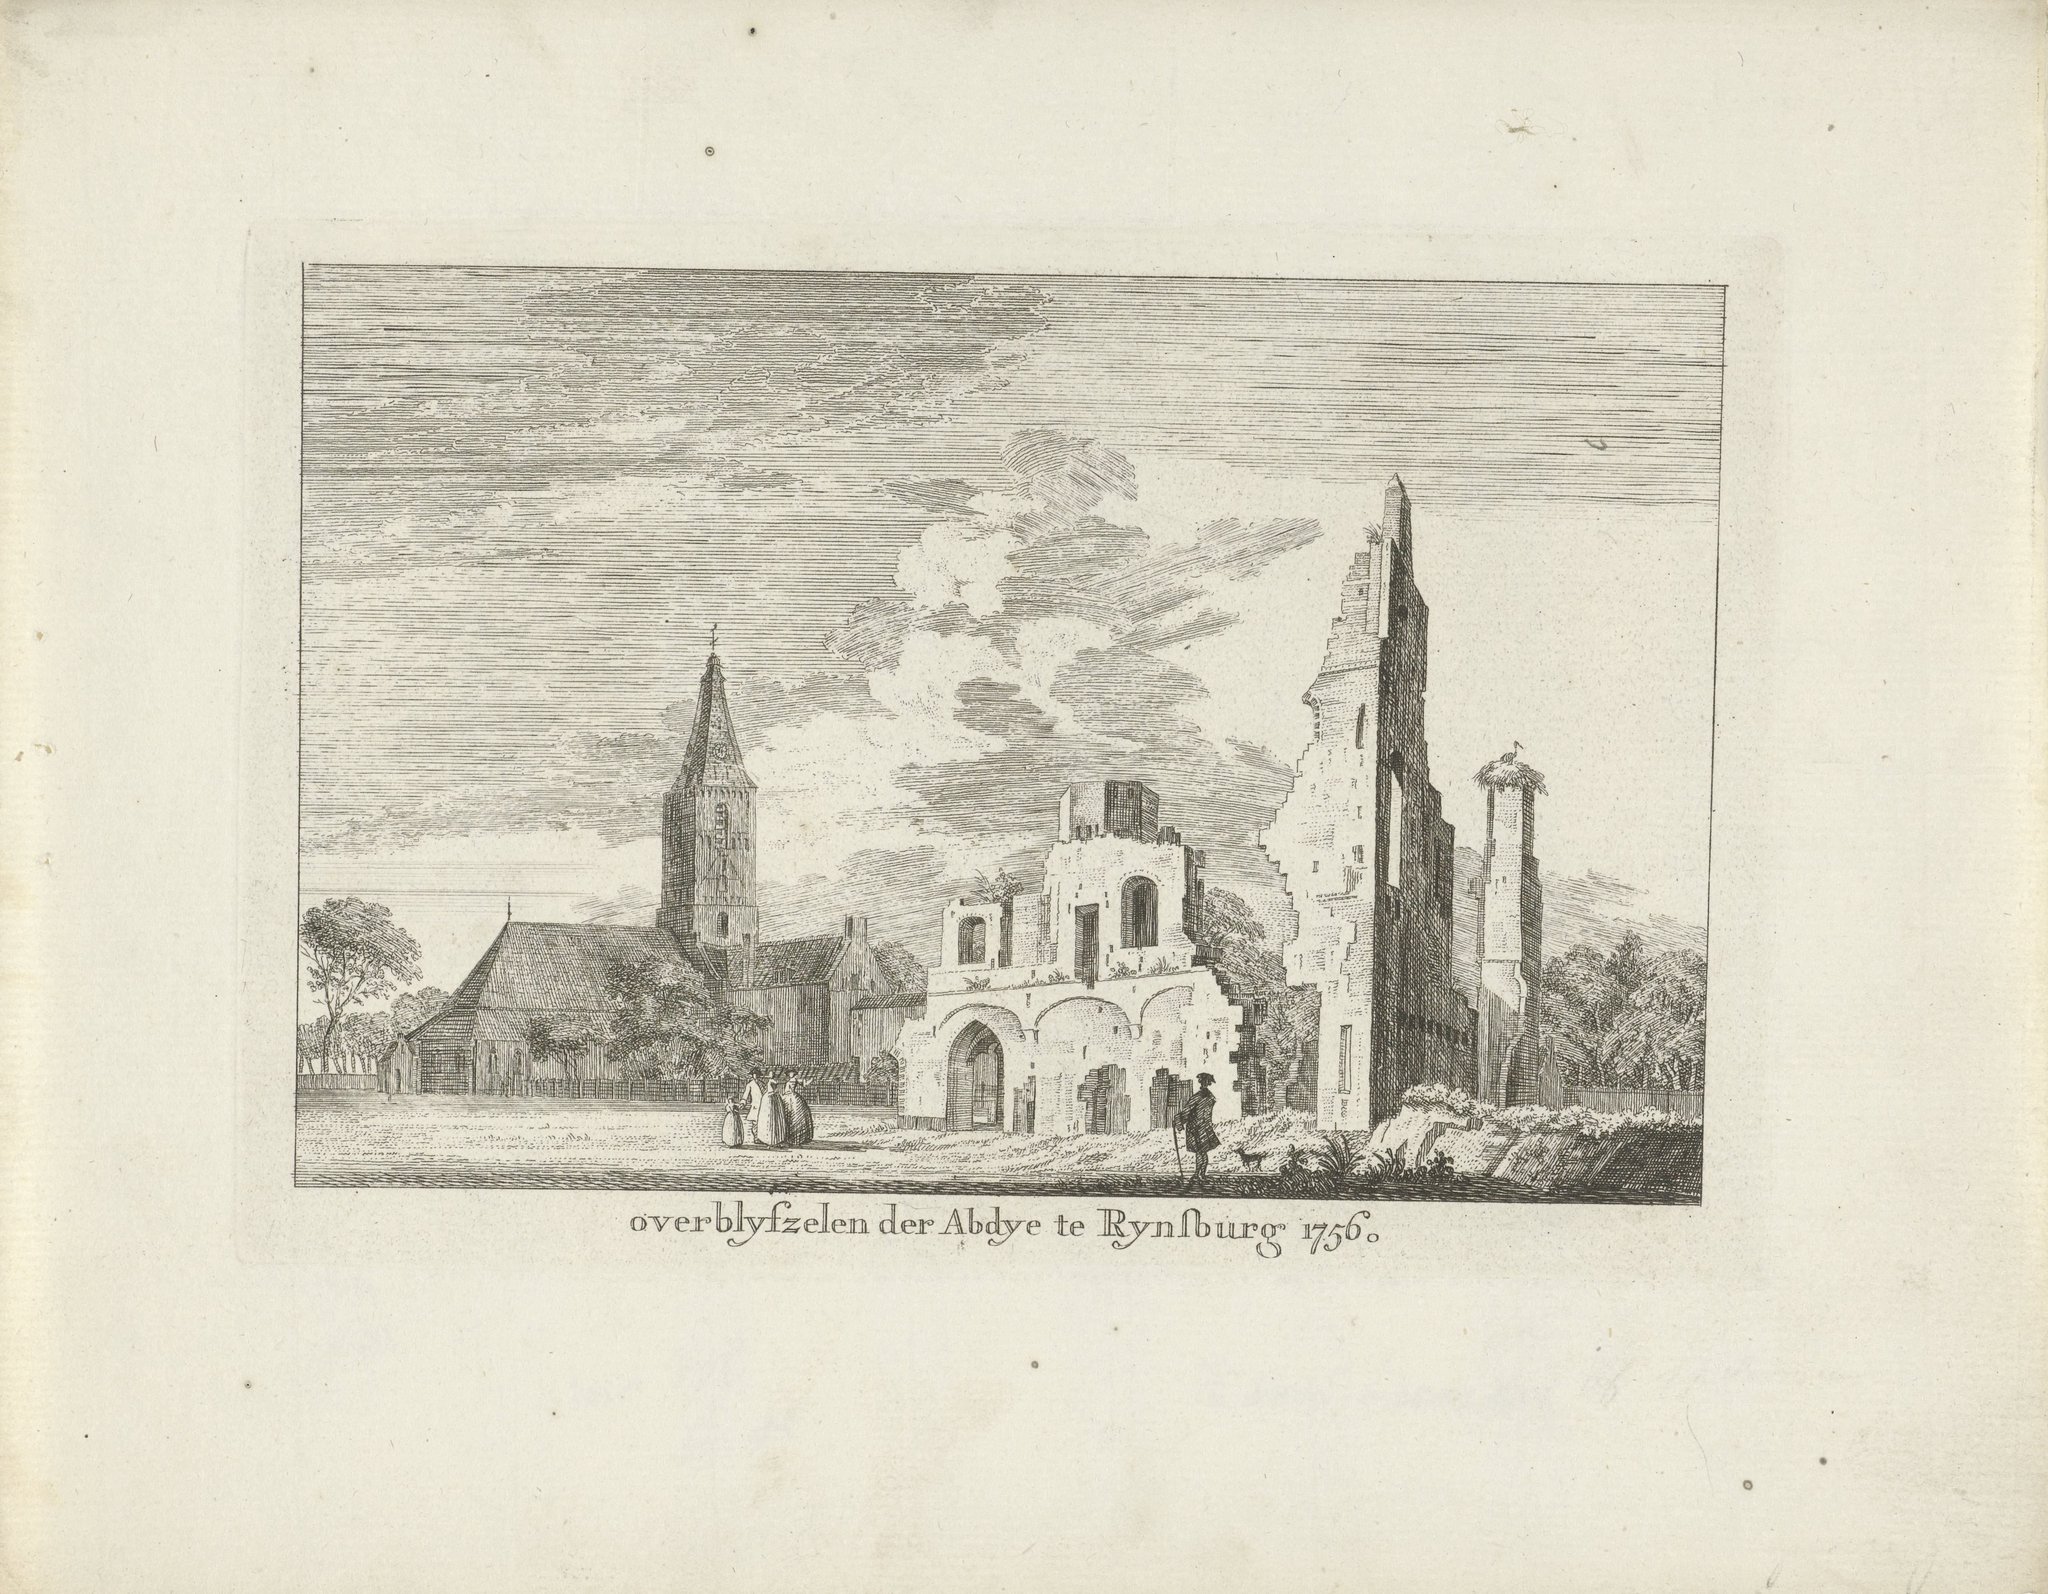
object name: print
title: Ruïne van de abdij van Rijnsburg, 1756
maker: paulus van liender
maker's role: draughtsman, print maker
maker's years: 1731-1797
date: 1741-1797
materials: paper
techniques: etching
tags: ruin of church, monastery, etc.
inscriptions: collector's mark: Lugt 2228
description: Gezicht op de abdij te Rijnsburg en de naastgelegen kerk. Rechts op de voorgrond staat een man met een hond, links bezichtigt een groep figuren de ruïne.